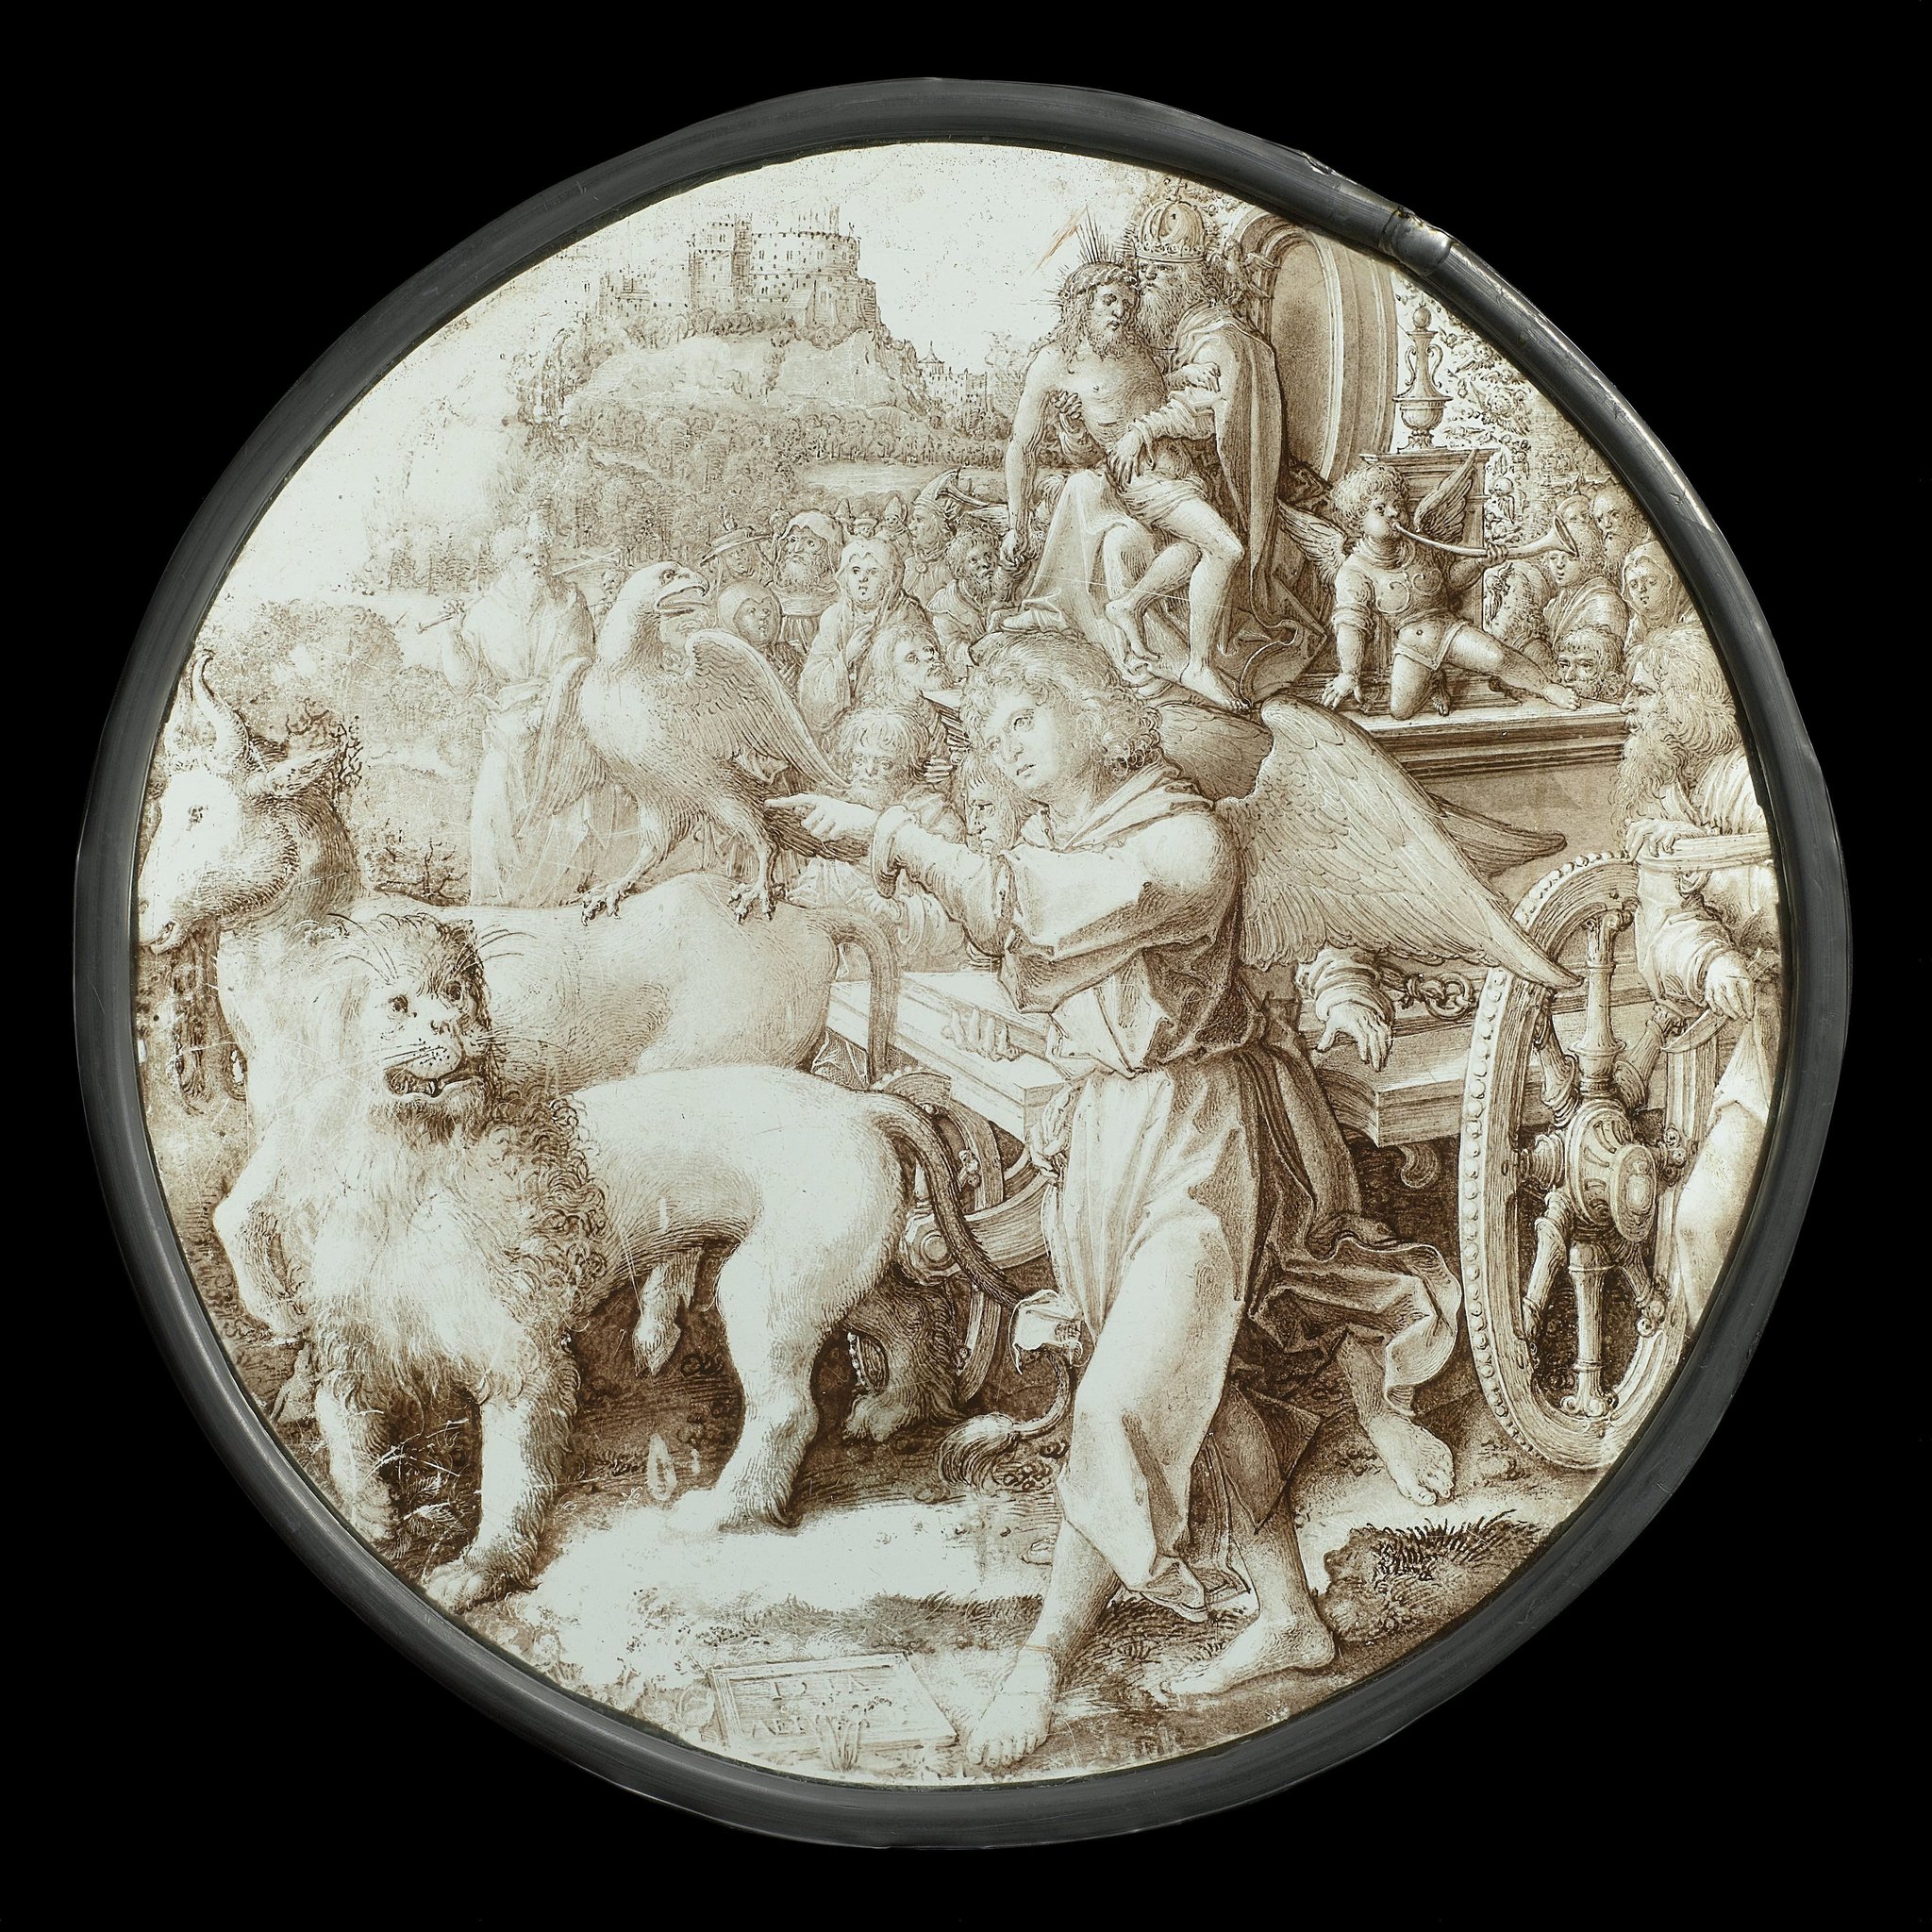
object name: light window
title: The Triumph of Eternity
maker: dirck vellert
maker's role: draughtsman, painter, print maker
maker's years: 1480-1547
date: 1517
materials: glass, lead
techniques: leading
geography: antwerp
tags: 'trionfo della divinità', 'triumphus aeternitatis'; 'carro della divinità', the four symbols of the evangelists, 'the apocalyptic beasts', landscape with tower or castle, god the father holding the crucified or dead christ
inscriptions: date: ‘1517 // MEI’, monogram: ‘D*V’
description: Ronde, gebrandschilderde ruit met voorstelling van de Triomf van de Eeuwigheid. Tegen een achtergrond van een bergachtig landschap met een stad rijdt een klassieke triomfkar. Op de kar, op een rechthoekig voetstuk, troont God de Vader, getooid met mijter. Hij ondersteunt op zijn schoot het dode lichaam van zijn zoon Christus. Achter hem vliegt een duif, de Heilige Geest. Zij vormen de heilige Drie-eenheid, die de eeuwigheid symboliseert. Aan weerkanten van de troon hurkt een bazuinblazende engel. De kar wordt voorafgegaan door de attributen van de vier evangelisten: de engel van Mattheus, de leeuw van Marcus, de stier van Lucas en de adelaar van Johannes. Zij verbeelden het Nieuwe Testament. De driewielige kar (de heilige Drie-Eenheid) wordt getrokken door twee mannen, waarvan de één grotendeels schuil gaat achter de engel, die met de rechterhand het Evangelie openhoudt en met de linkerhand de weg wijst aan de mensen die achter de kar drommen en waaronder zich heiligen, geestelijken en burgers bevinden. De tweede man, helemaal rechts in beeld, duwt met zijn linkerhand tegen een band die om zijn schouders ligt en waarmee hij de kar trekt. In de andere hand houdt hij een mes.